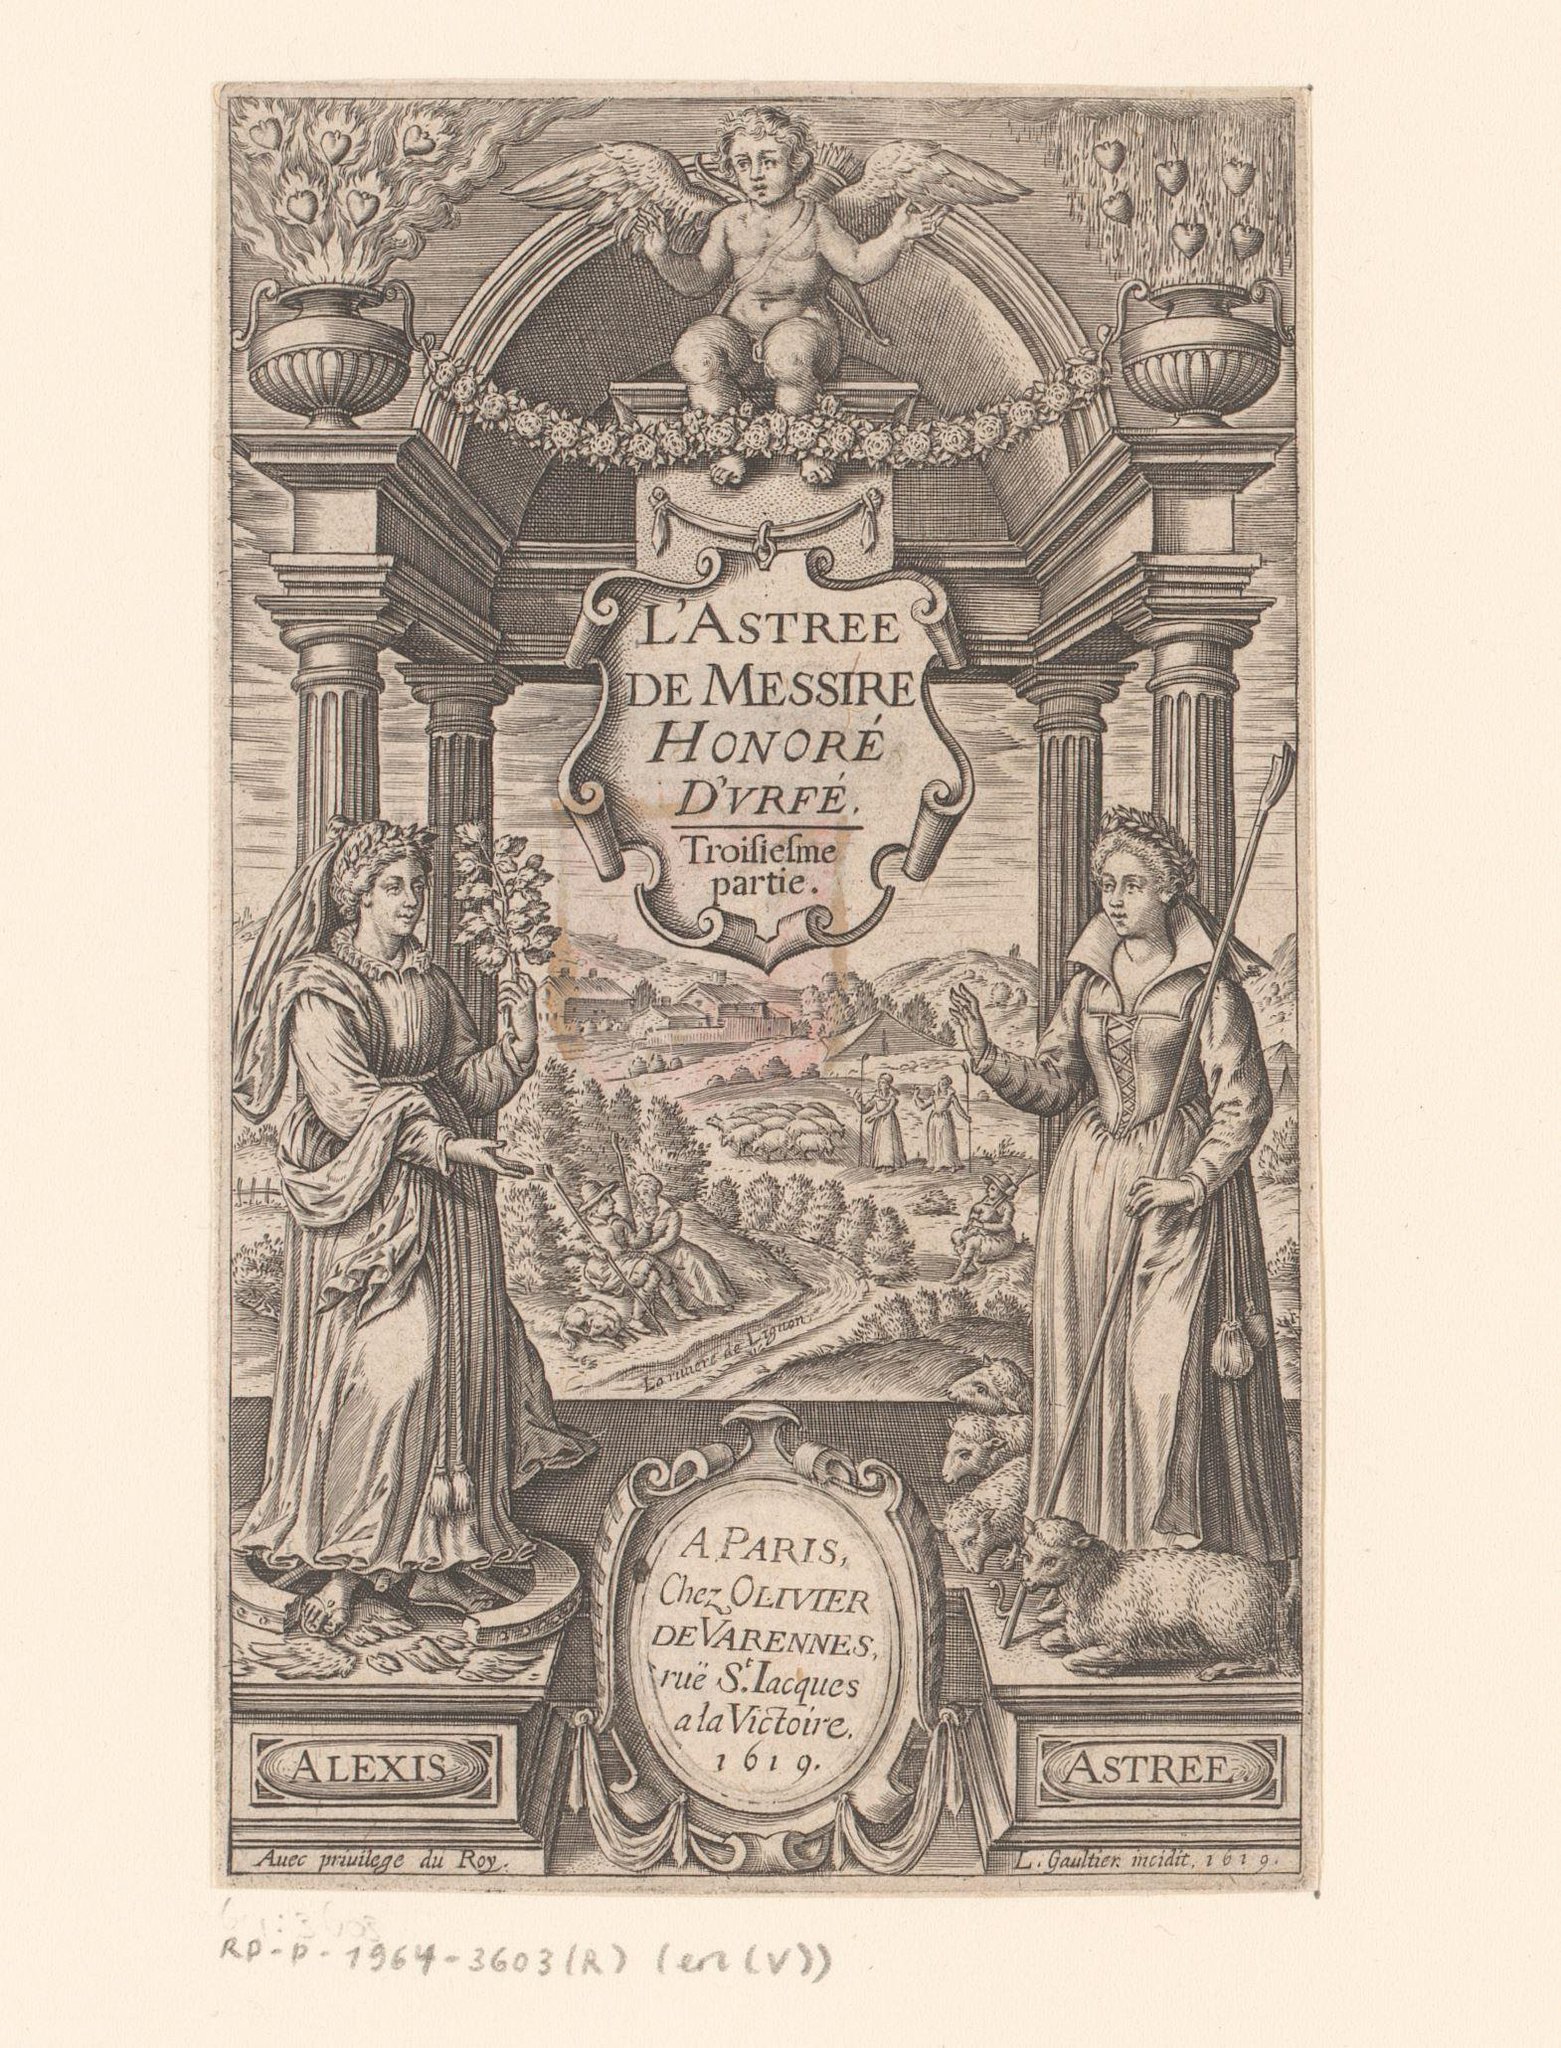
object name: titelblad, titelpagina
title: Titelpagina voor: Honoré d'Urfé, L'Astrée de Messire, 1619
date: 1619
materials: paper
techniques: engraving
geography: paris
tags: (scenes from) specific works of literature: d'urfé, astrée, sheep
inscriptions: collector's mark: Lugt 2228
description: Titelpagina voor: D'Urfé, Honoré. L'Astrée de Messire. Parijs: Olivier de Varennes, 1619, dl. 3.